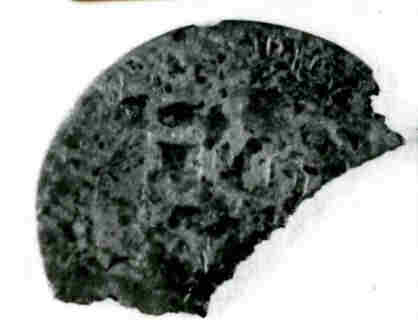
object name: coin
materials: copper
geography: iran